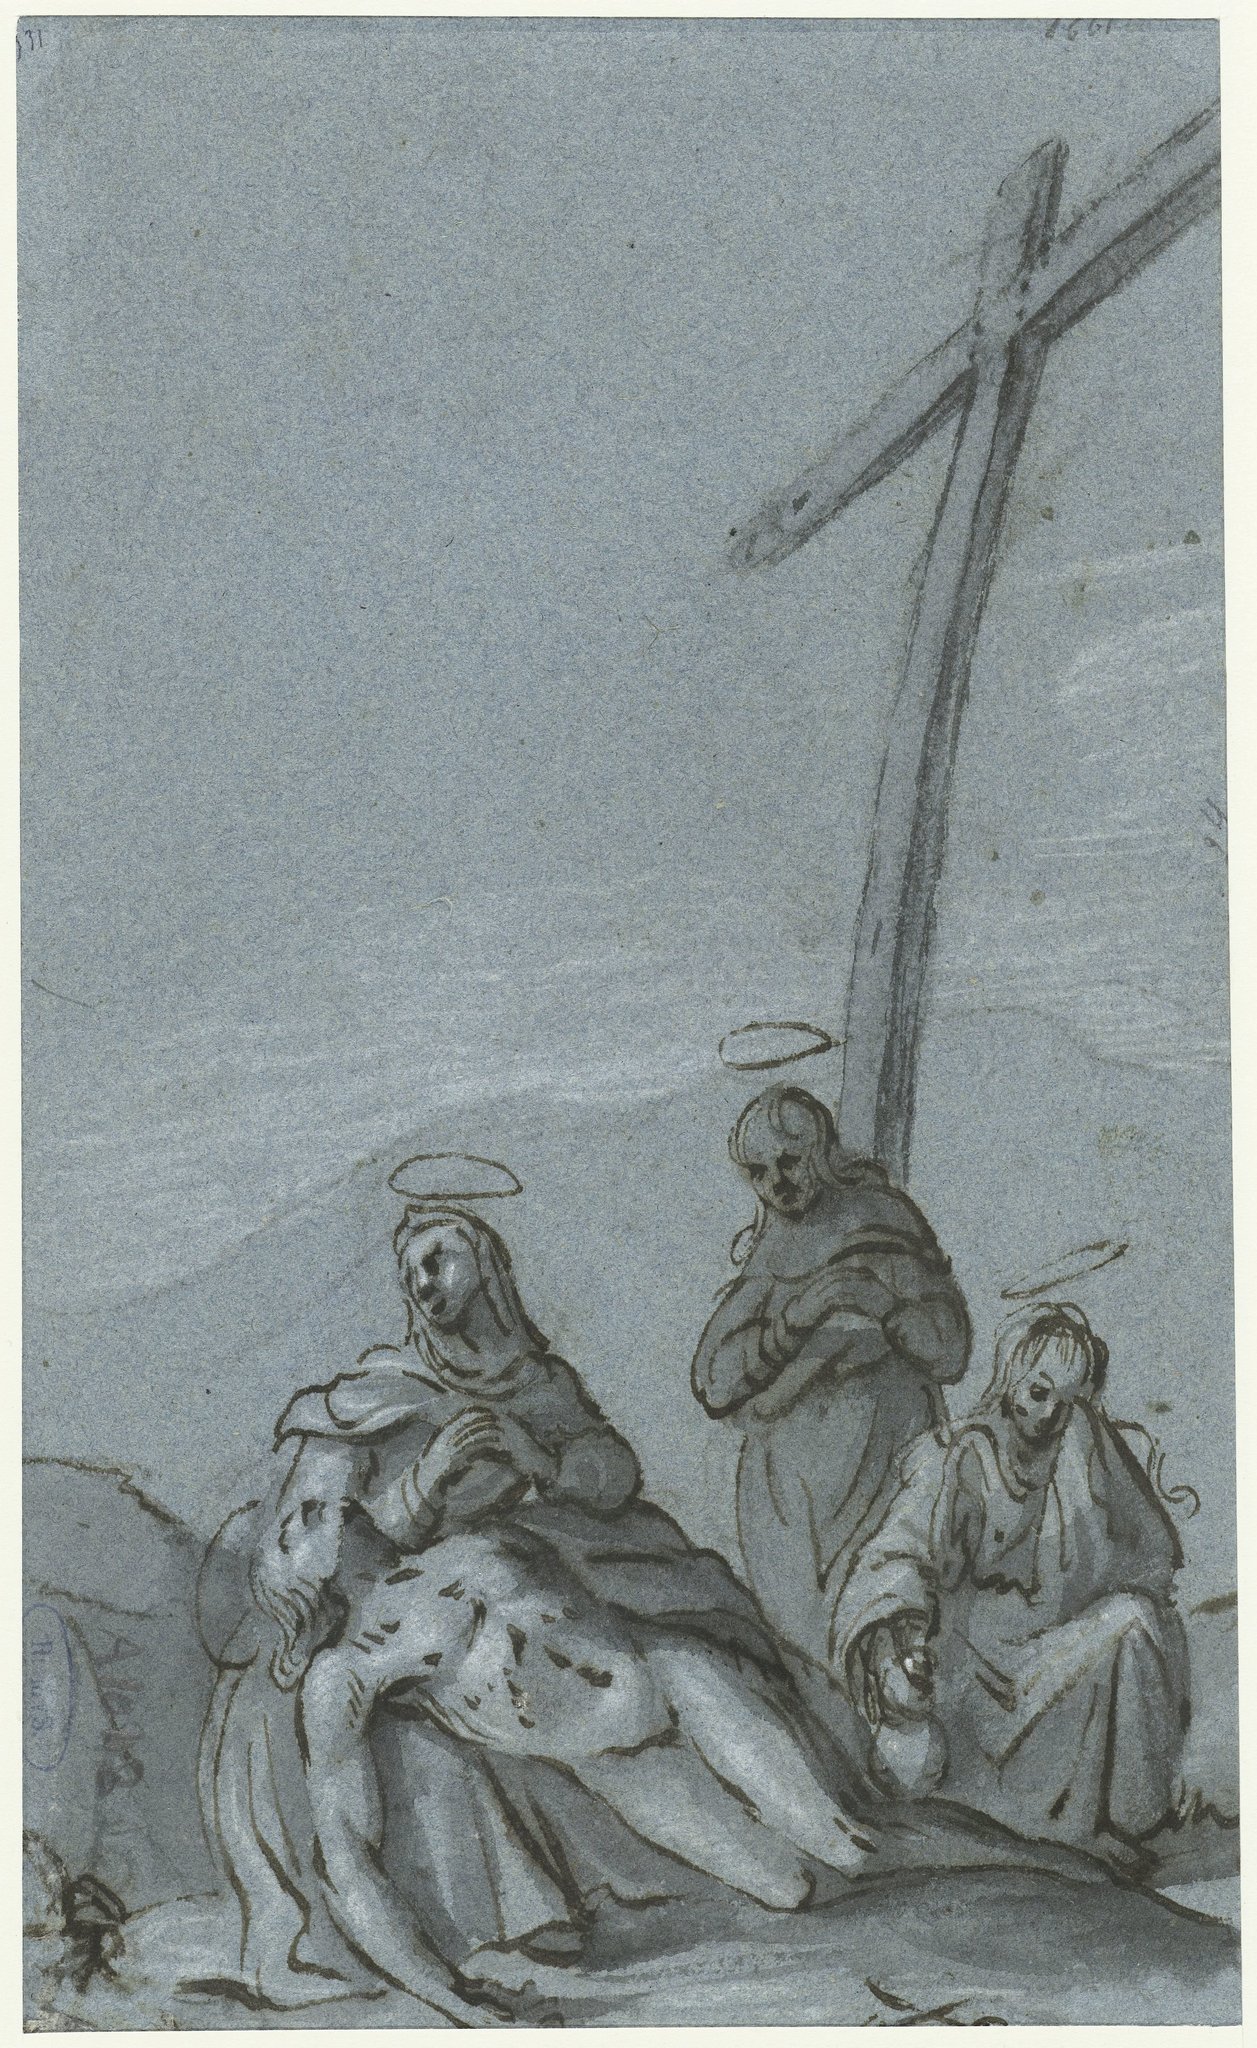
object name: drawing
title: Lamentation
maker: moses ter borch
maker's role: draughtsman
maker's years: 1645-1667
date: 1661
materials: chalk, ink, paper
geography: zwolle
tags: lamentation over the dead christ by his relatives and friends (christ usually without crown of thorns)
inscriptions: annotation: ‘24’, date: ‘1661’